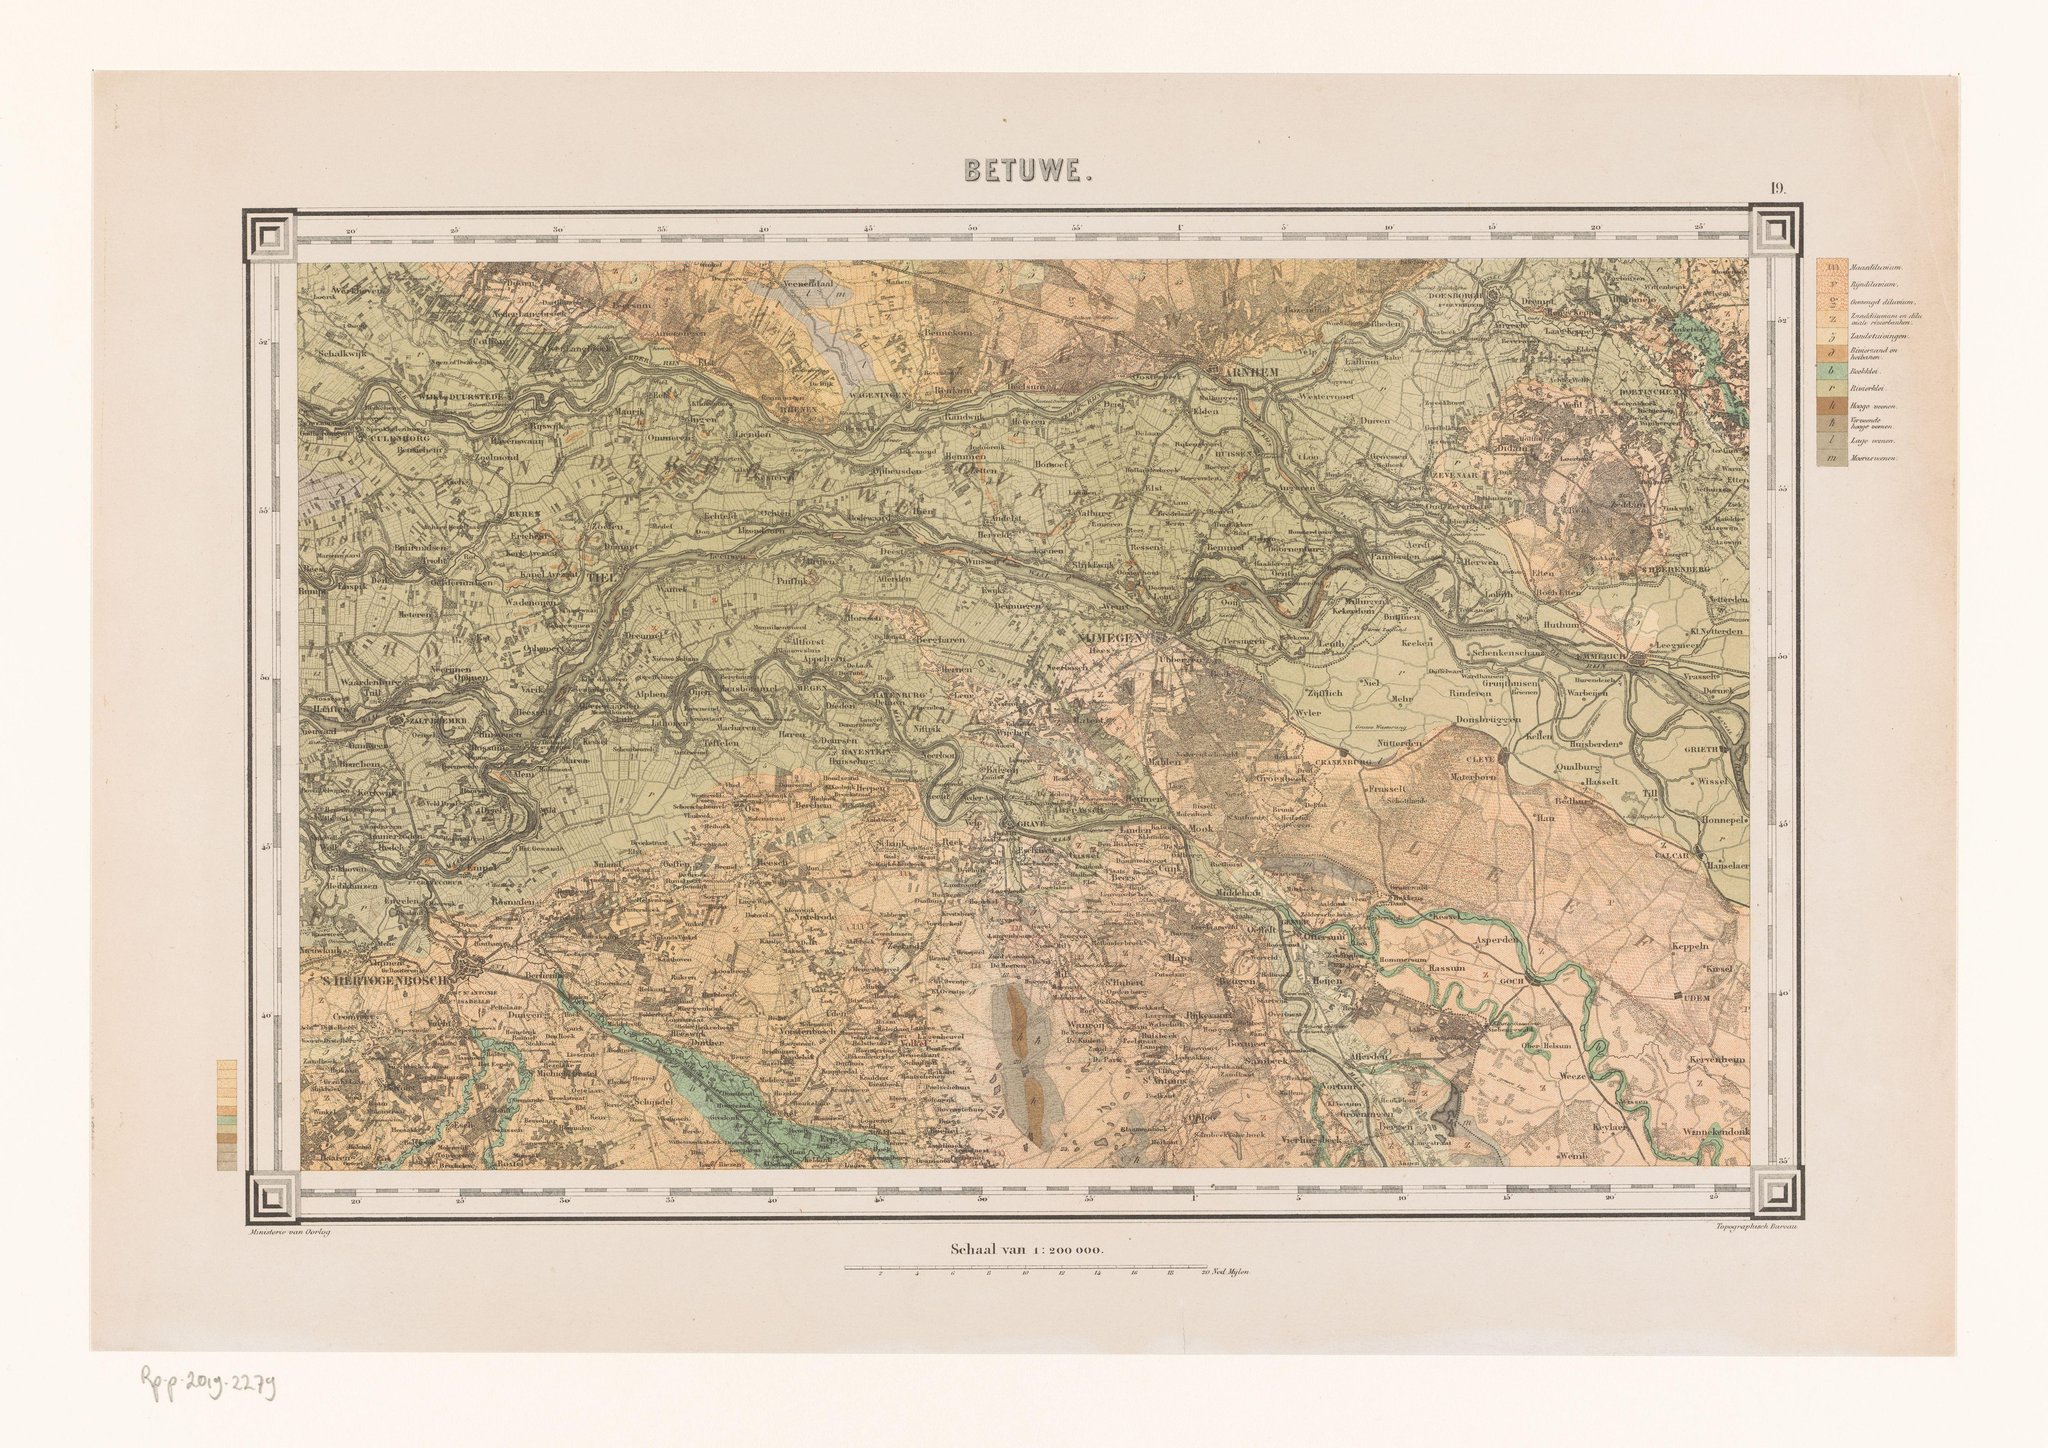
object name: map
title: Kaart van de Betuwe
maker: Anonymous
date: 1850-1949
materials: paper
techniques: lithograph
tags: maps of separate countries or regions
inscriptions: collector's mark: Lugt 2228